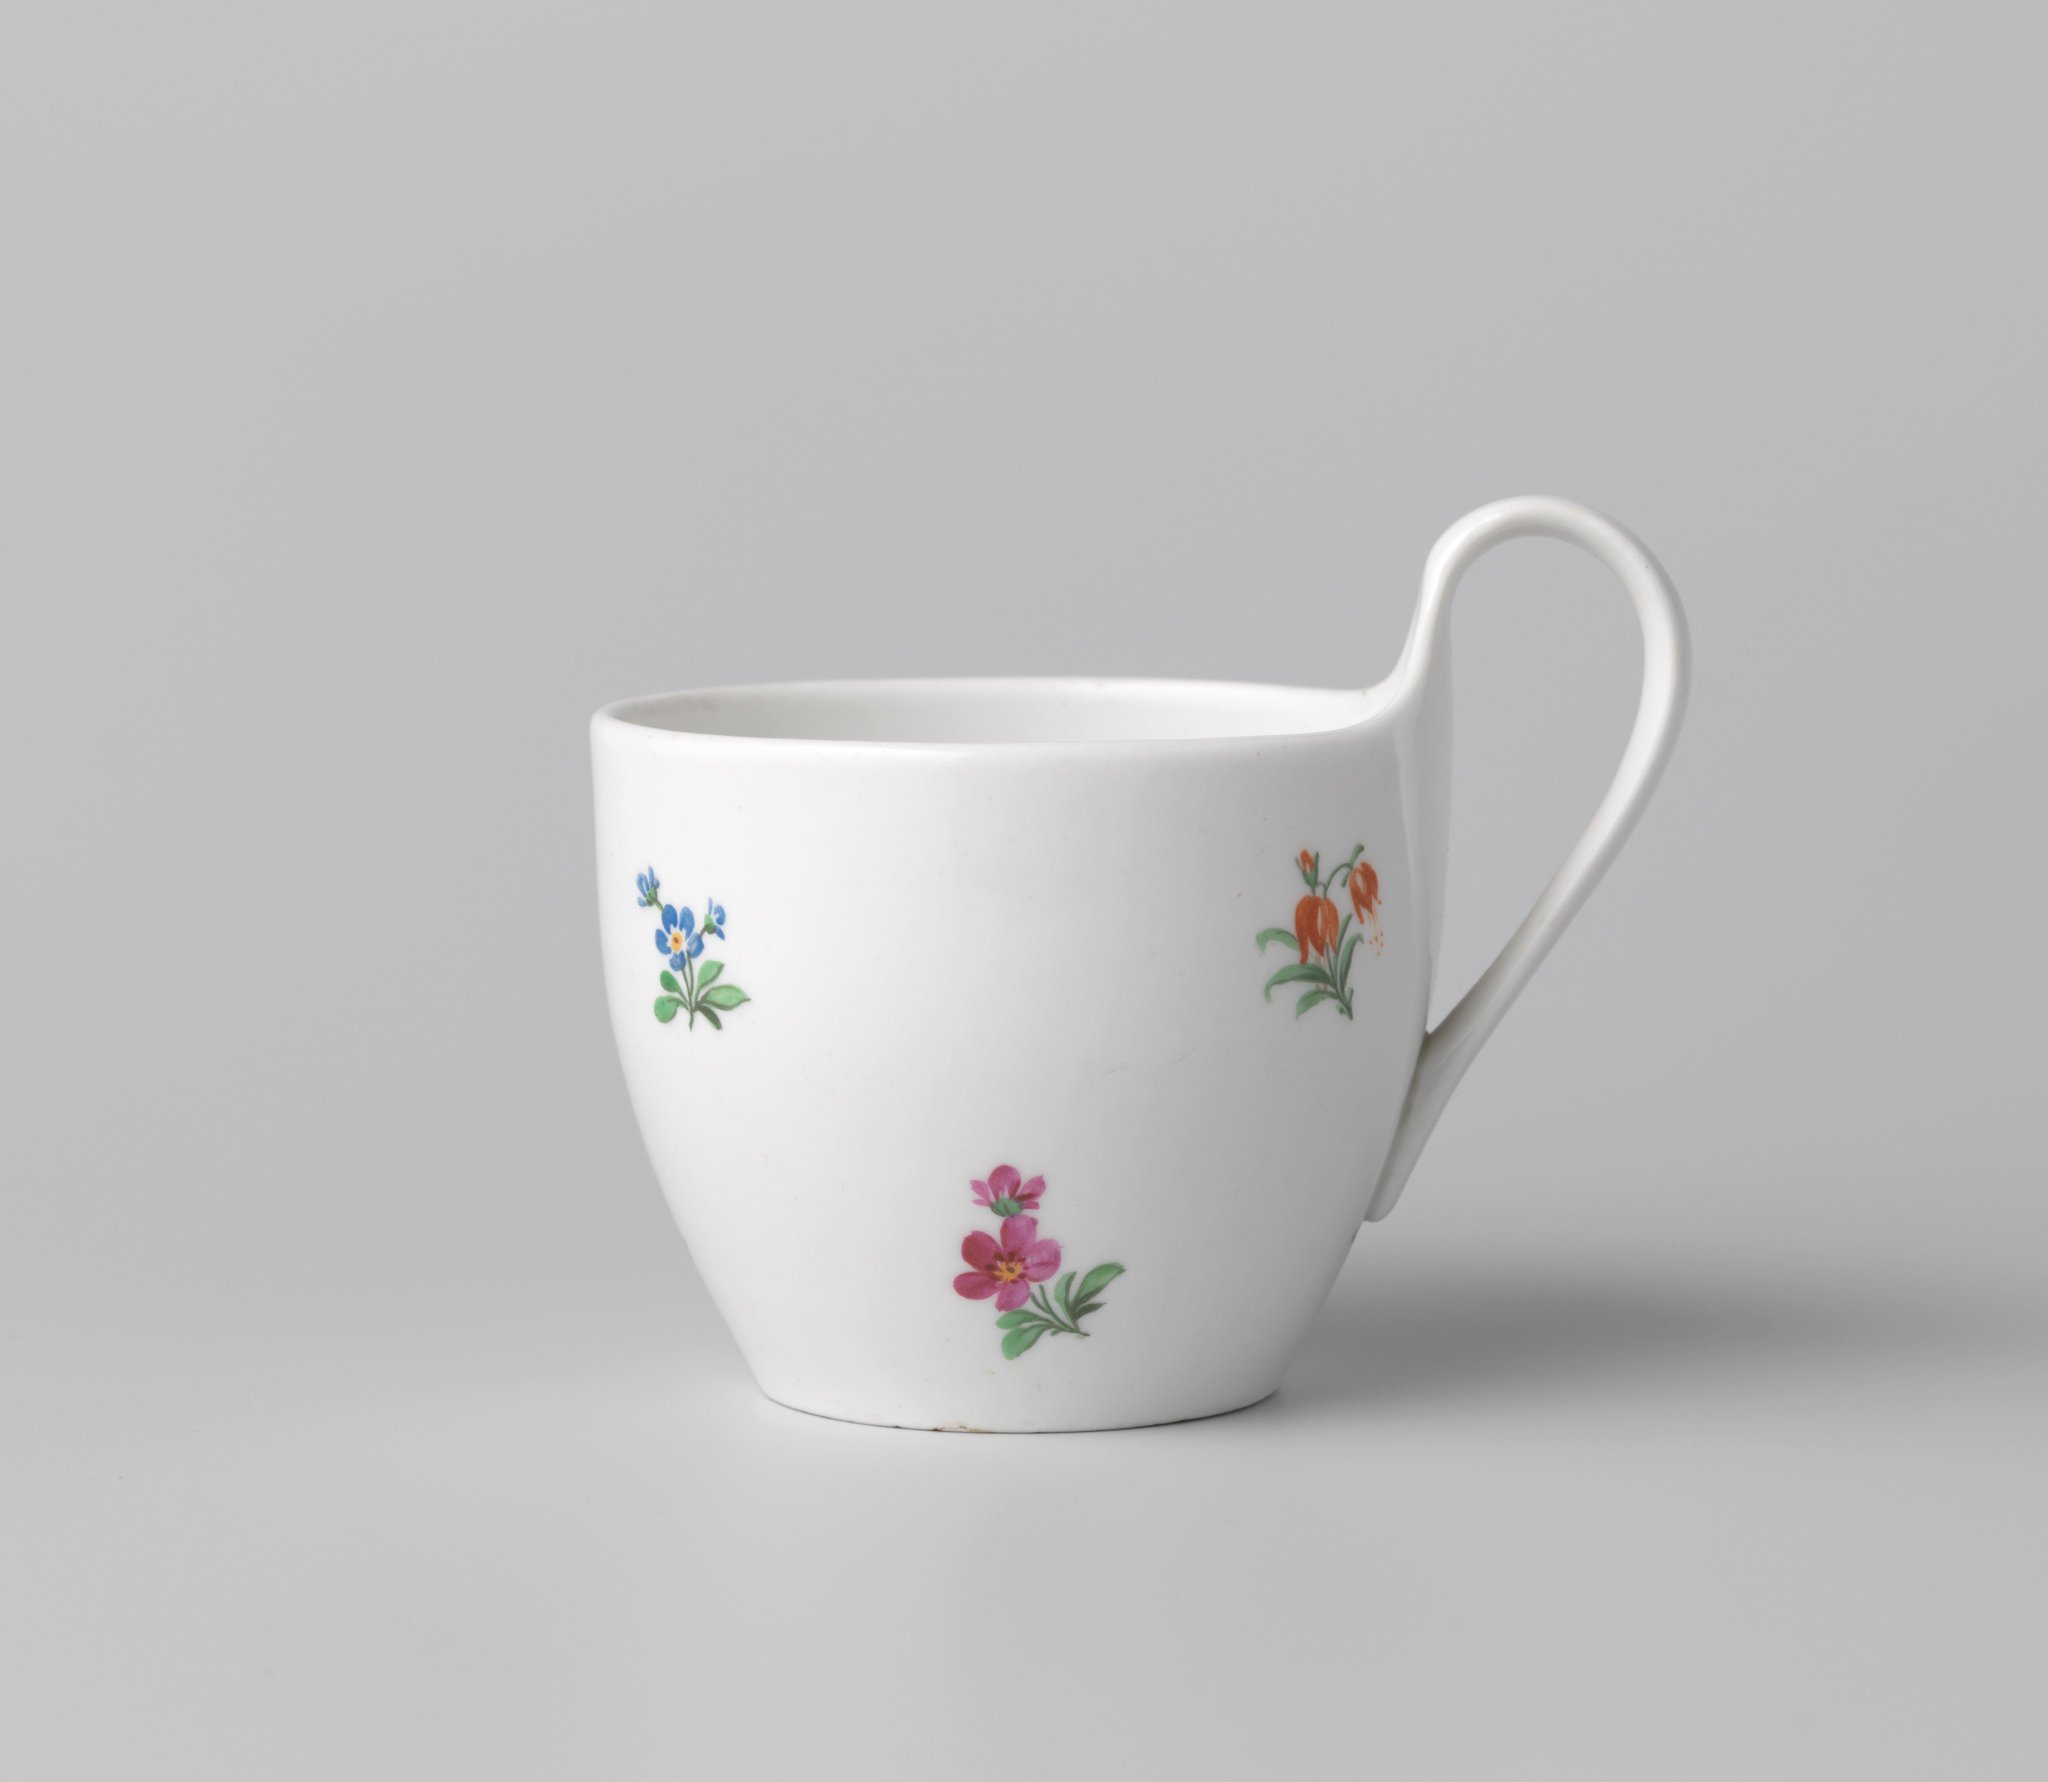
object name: cup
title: Cup with flowers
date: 1849-1870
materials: glaze, paint, porcelain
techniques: firing, turning, vitrification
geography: berlin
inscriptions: mark: ‘scepter met adelaar in medaillon en KOENIGL. PORZELLAN MANUFAKTUR/ rode rijksappel met K.P.M/ 14/ I’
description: Kop van porselein, beschilderd op het glazuur in blauw, rood, roze, groen, geel, paars en zwart. Iets ronde wand en hoog, ongelijk C-vormig oor. De buitenwand is bedekt met kleine strooibloemen. De binnenzijde is ongedecoreerd. Gemerkt op de onderzijde met de scepter waaronder een medaillon met de adelaar, een scepter en een globe in zijn klauwen. Het randschrift leest 'KOENIGL. PORZELLAN MANUFAKTUR'. Hierbij de rode rijksappel met K.P.M., het nummer 14 en I.